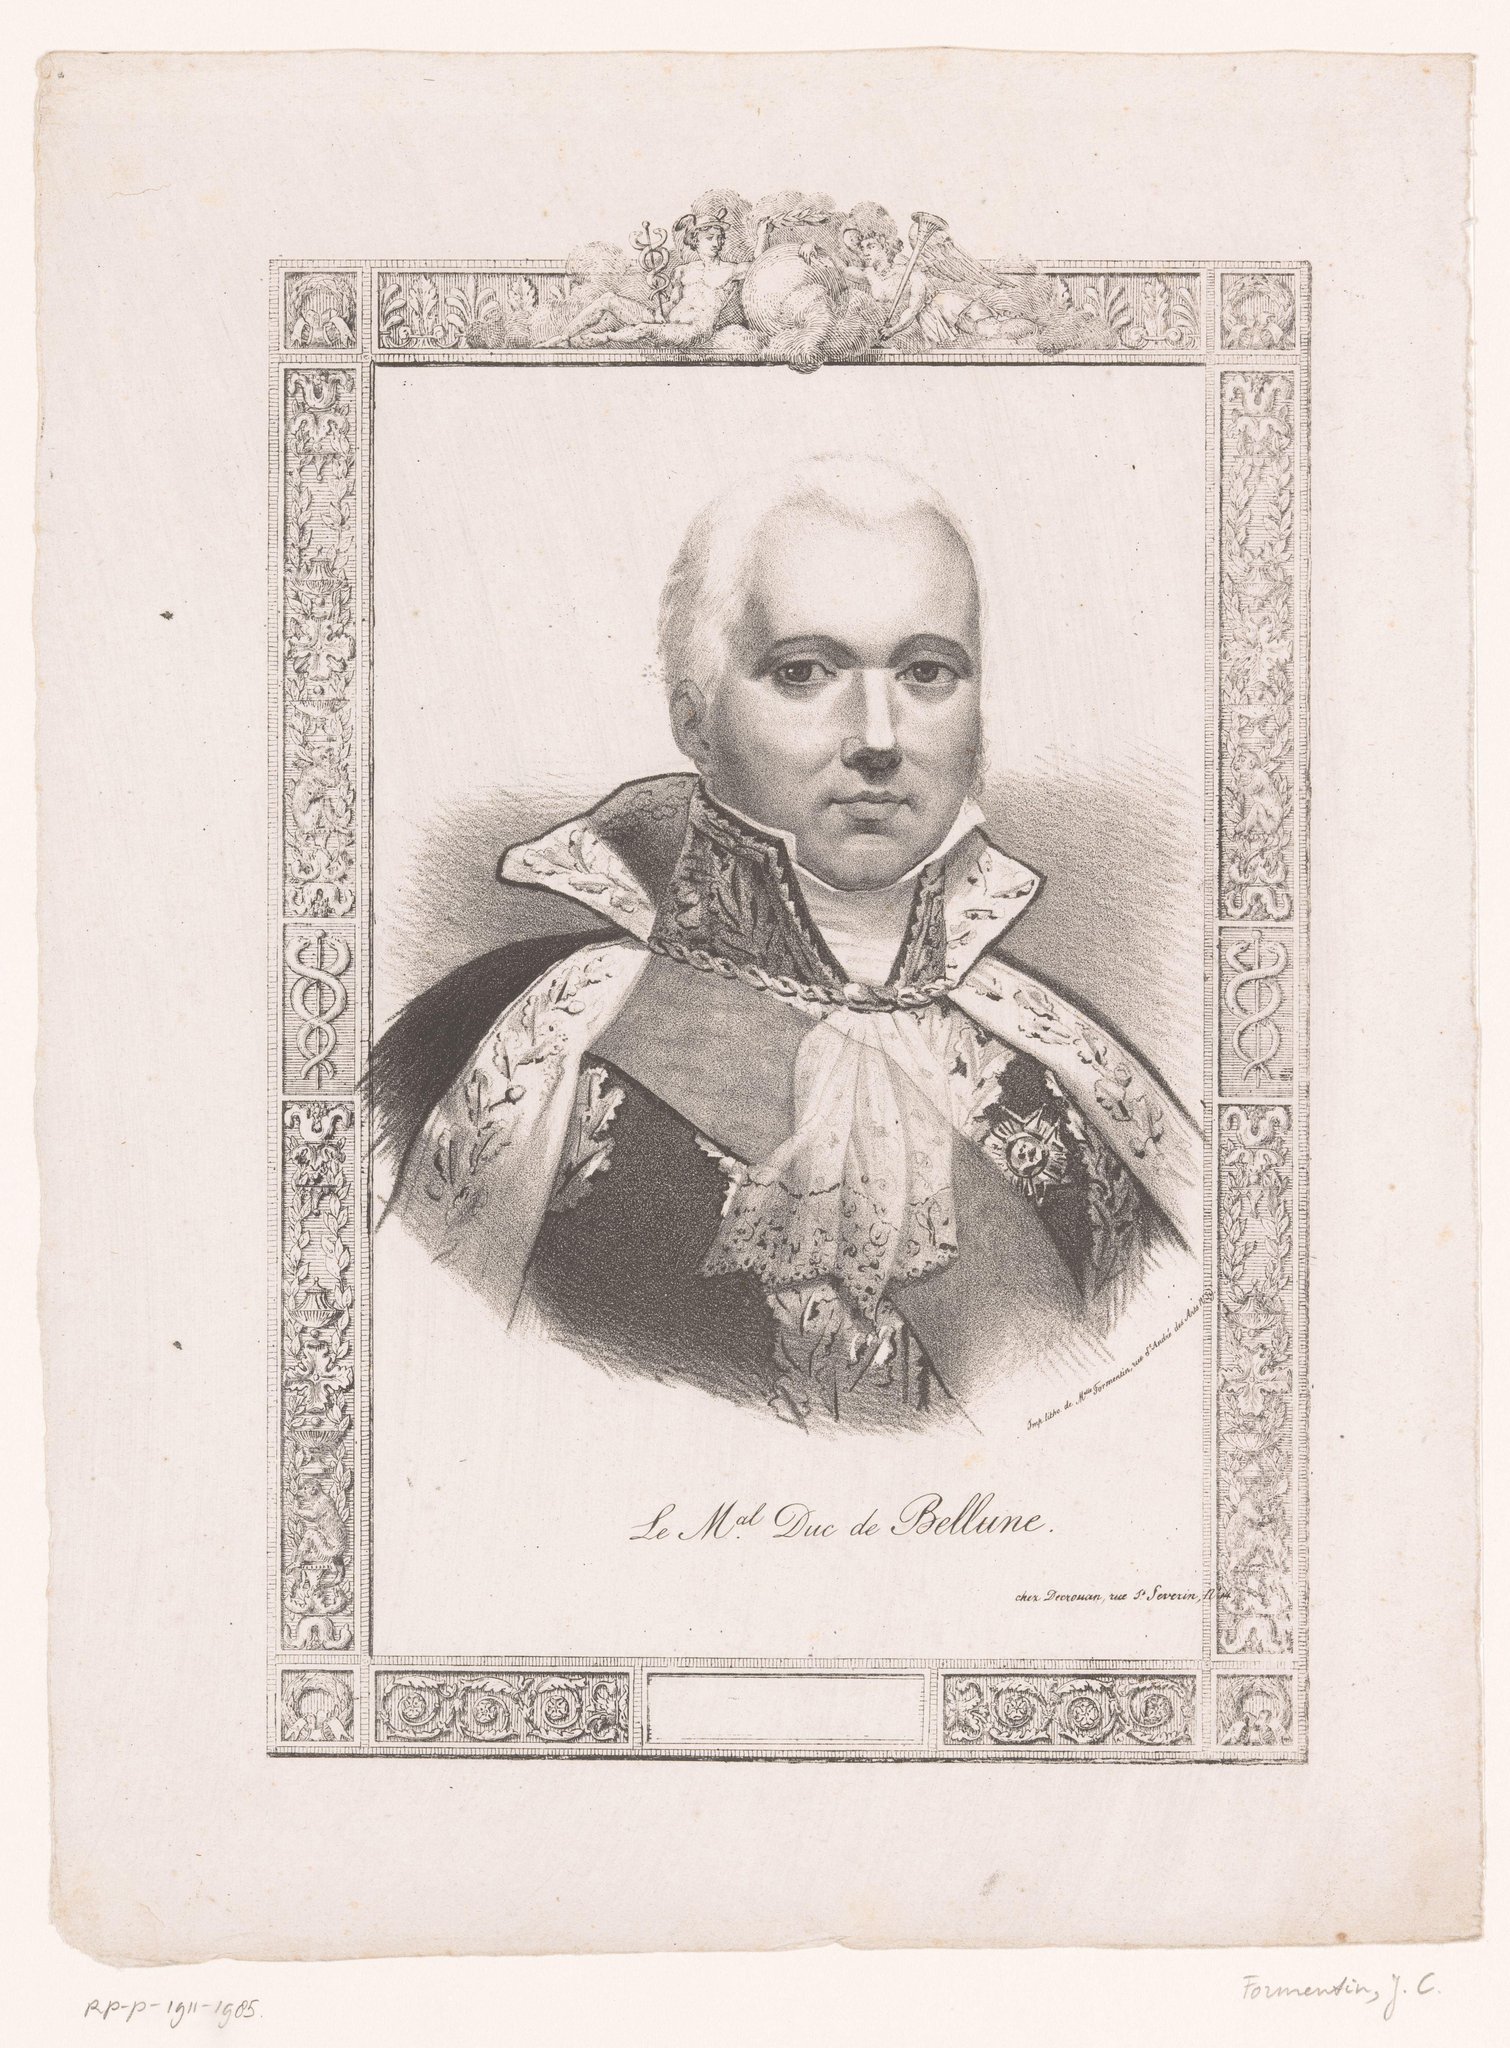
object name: print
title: Portret van Claude-Victor Perrin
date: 1824-1850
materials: paper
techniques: lithograph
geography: paris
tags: historical persons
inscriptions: collector's mark: Lugt 2228a